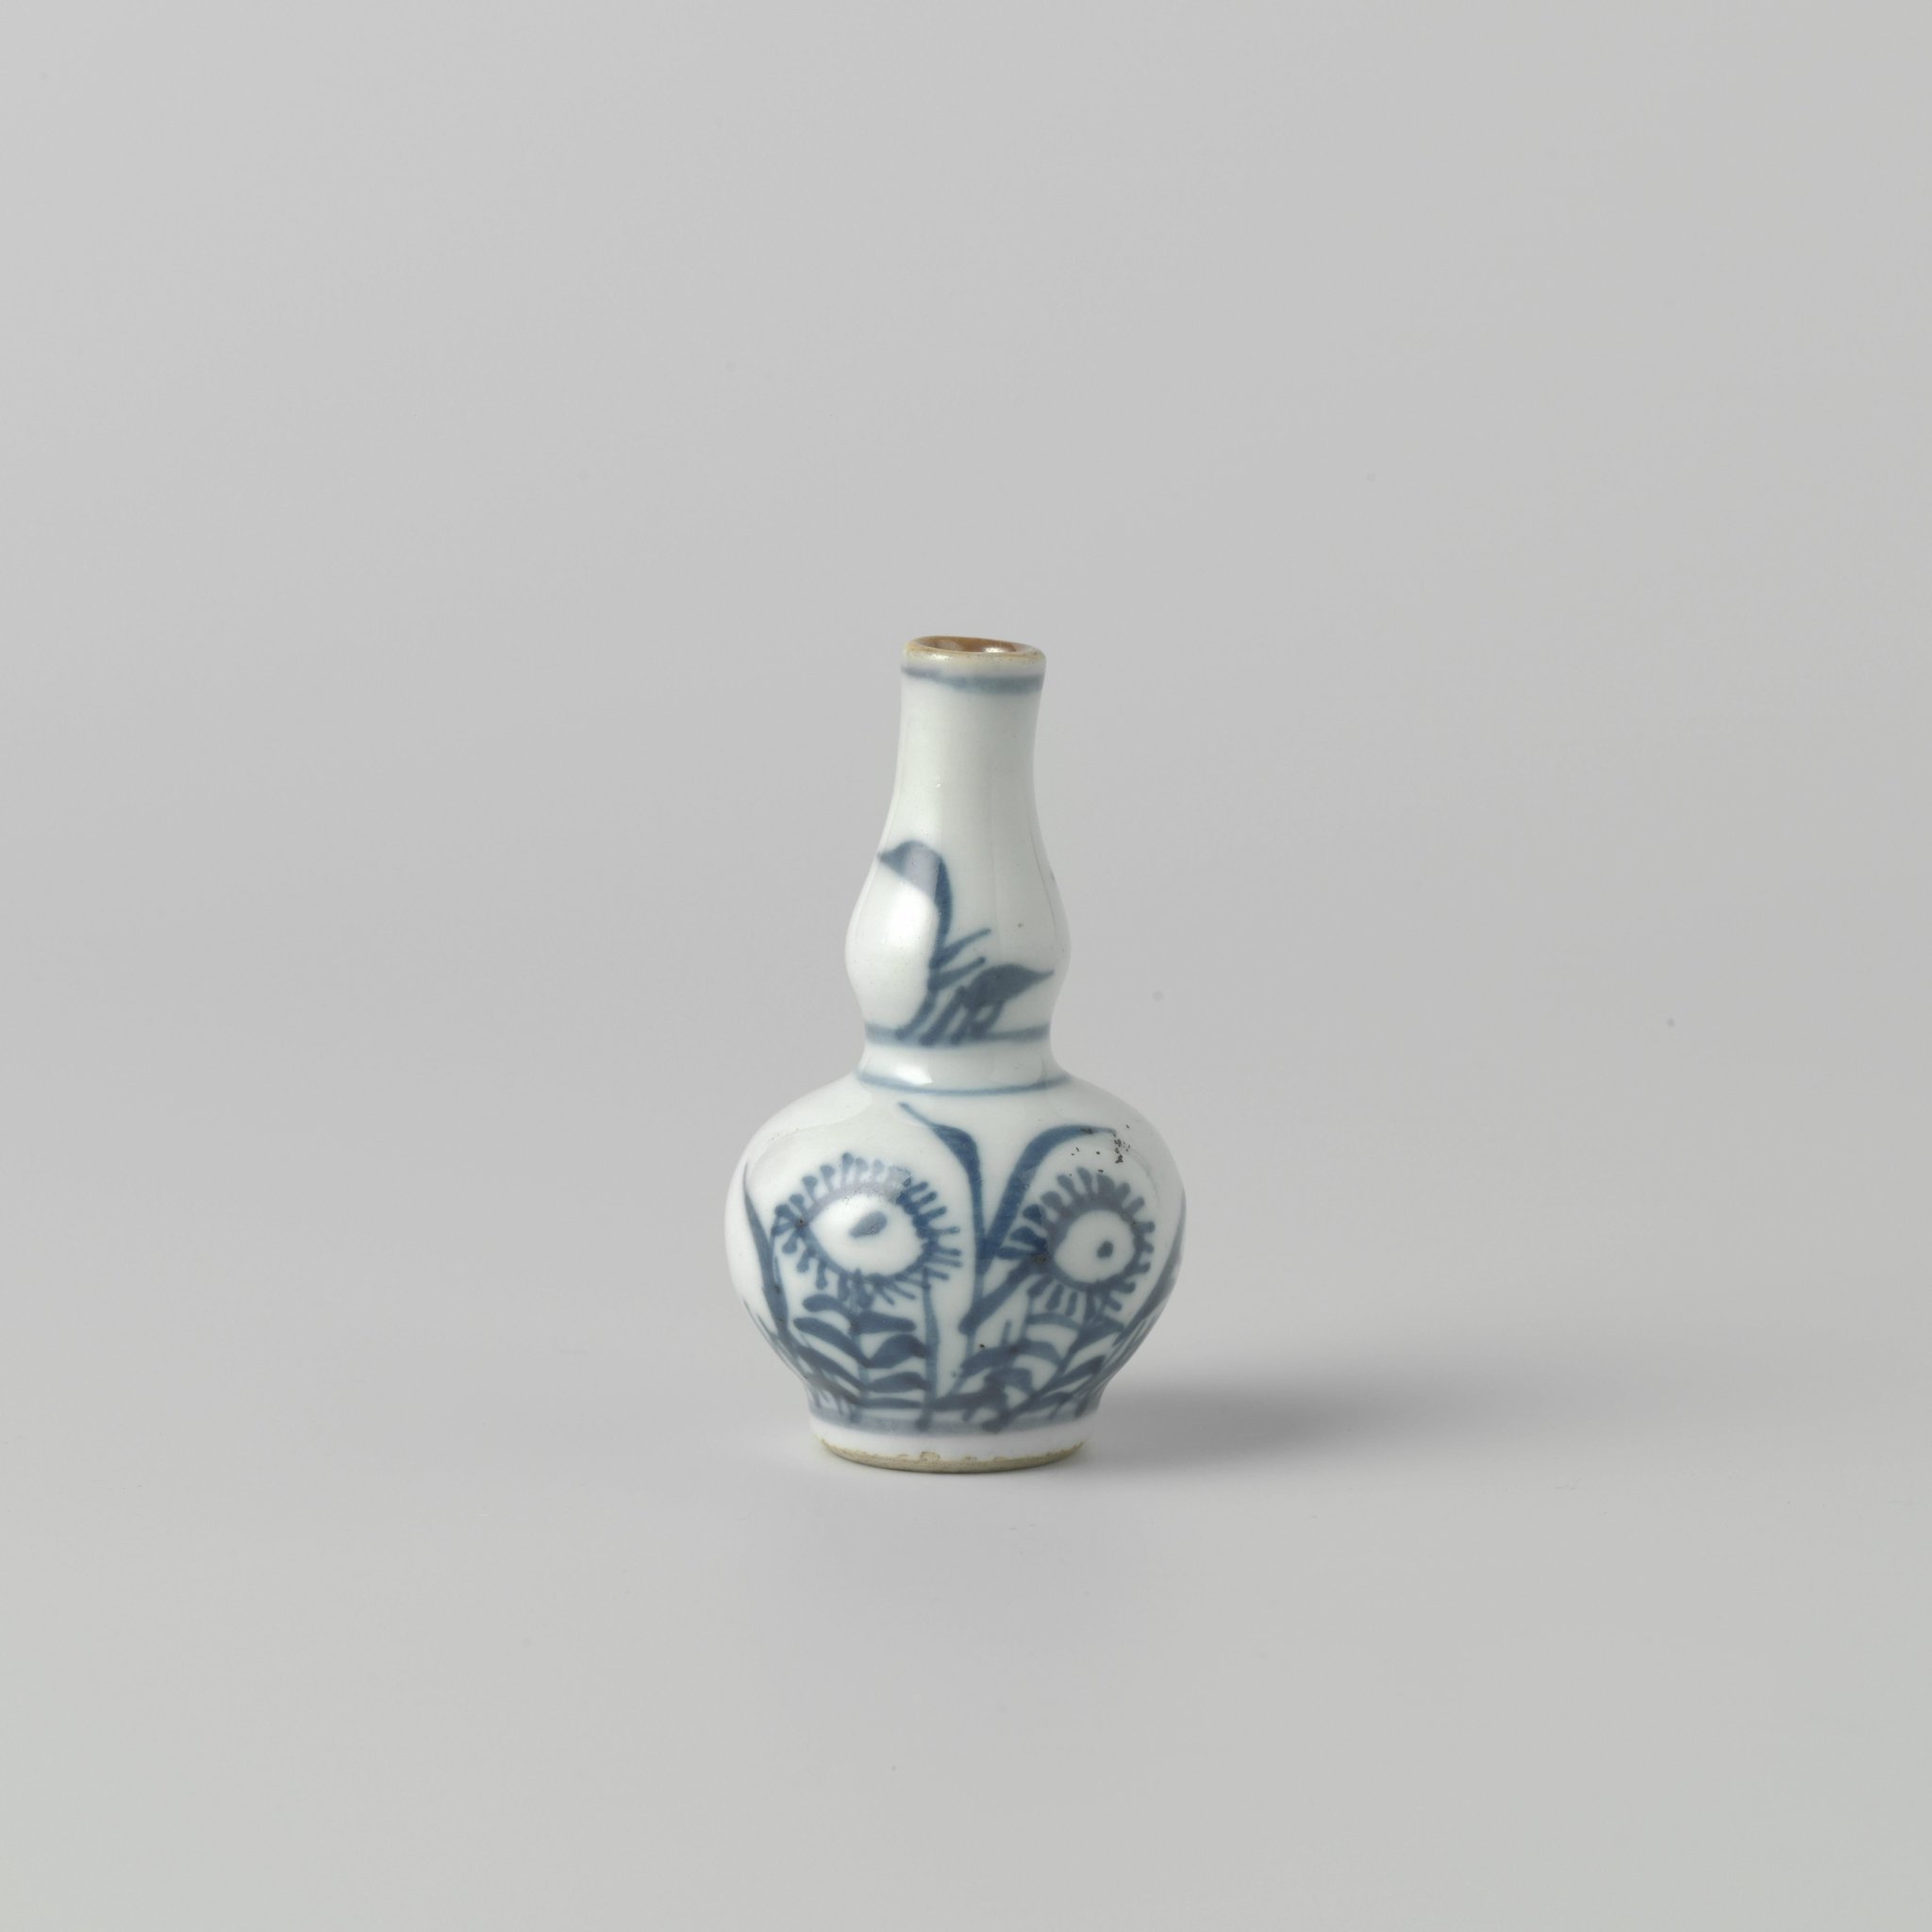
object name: vase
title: Miniature double gourd-shaped vase with flower sprays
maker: Anonymous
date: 1675-1724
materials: cobalt, glaze, paint, porcelain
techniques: firing, turning, vitrification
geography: china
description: Miniatuur kalebasvormige vaas van porselein, beschilderd in onderglazuur blauw. Op de buik een bloeiende plant (aster) en twijgjes. Op de nek twee bloemtakken. Blauw-wit.